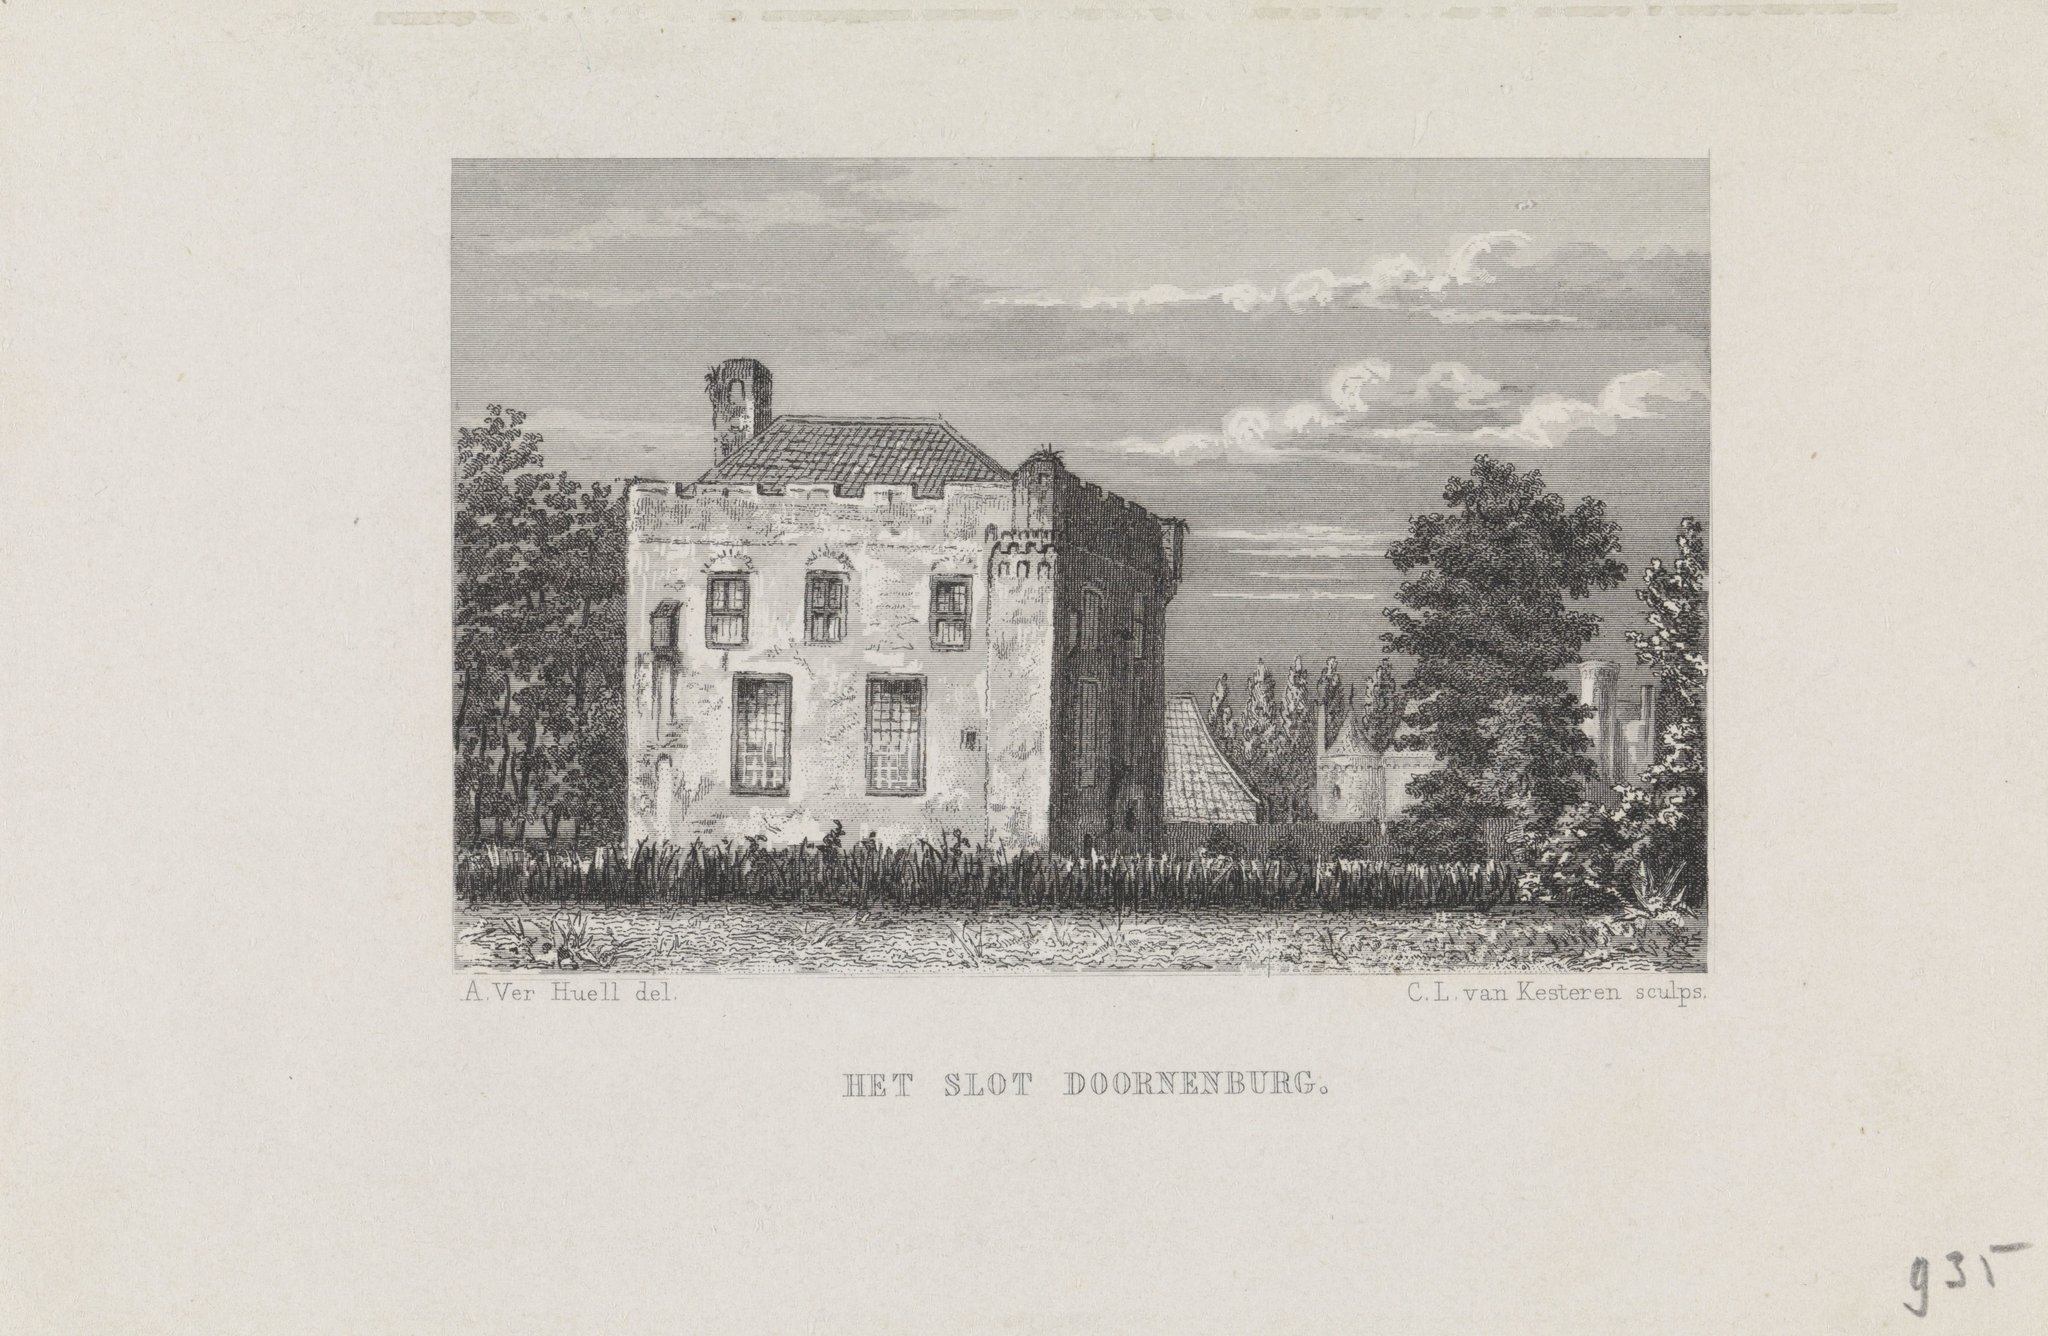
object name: print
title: Het slot Doornenburg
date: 1865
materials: paper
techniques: engraving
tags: castle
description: Prent mogelijk ook als illustratie gebruikt in: Geldersche Volksalmanak. Arnhem : Thieme. 1865, p. 84-92